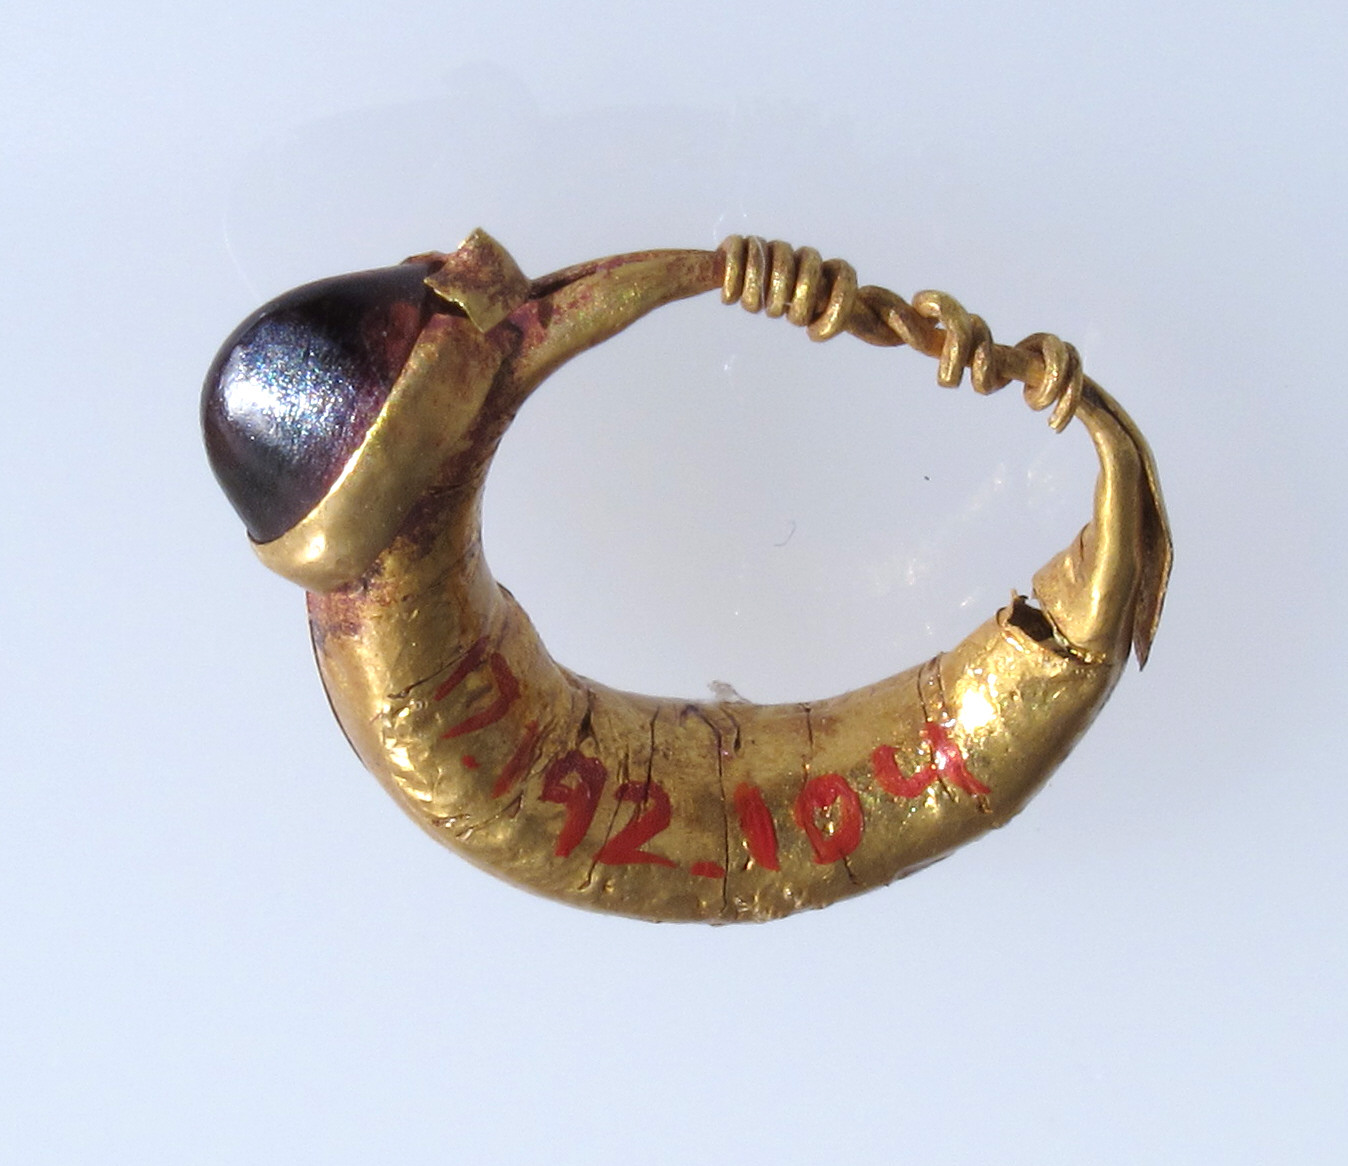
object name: earring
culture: pontic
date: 201-300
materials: gemstone, glass, gold, paste